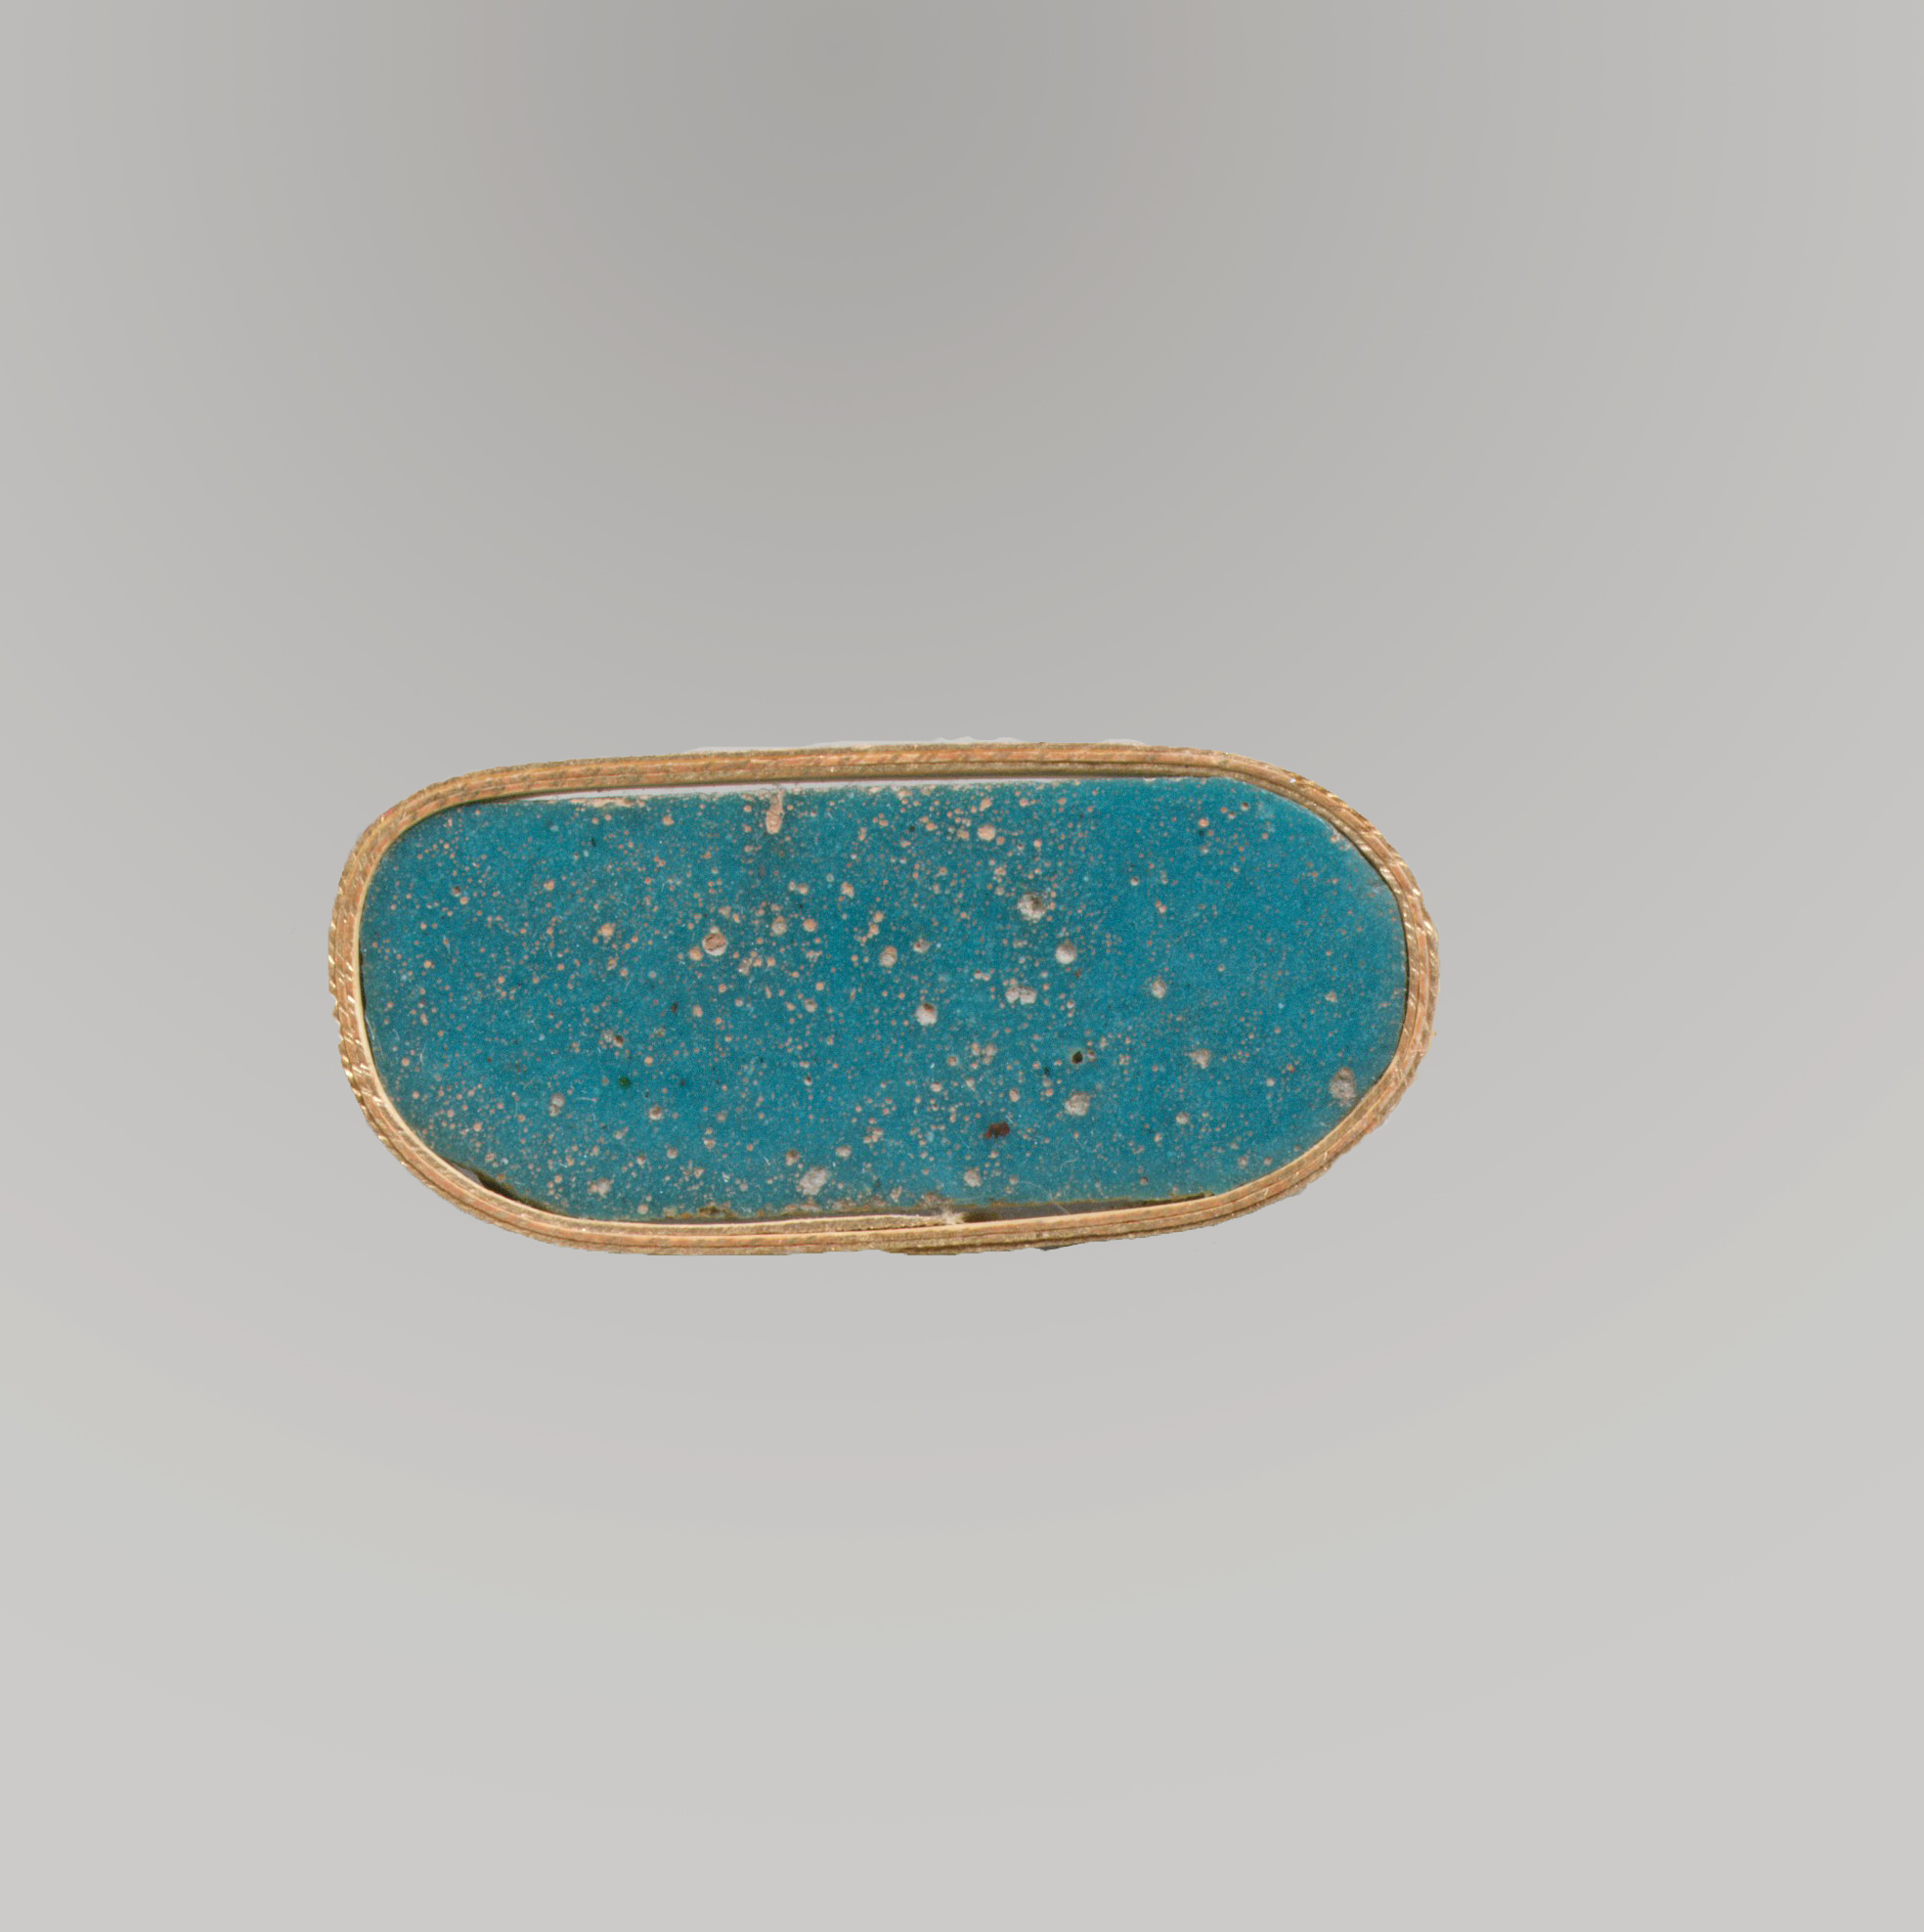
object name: inlay, monochrome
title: Glass monochrome inlay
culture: roman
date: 1-50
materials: glass